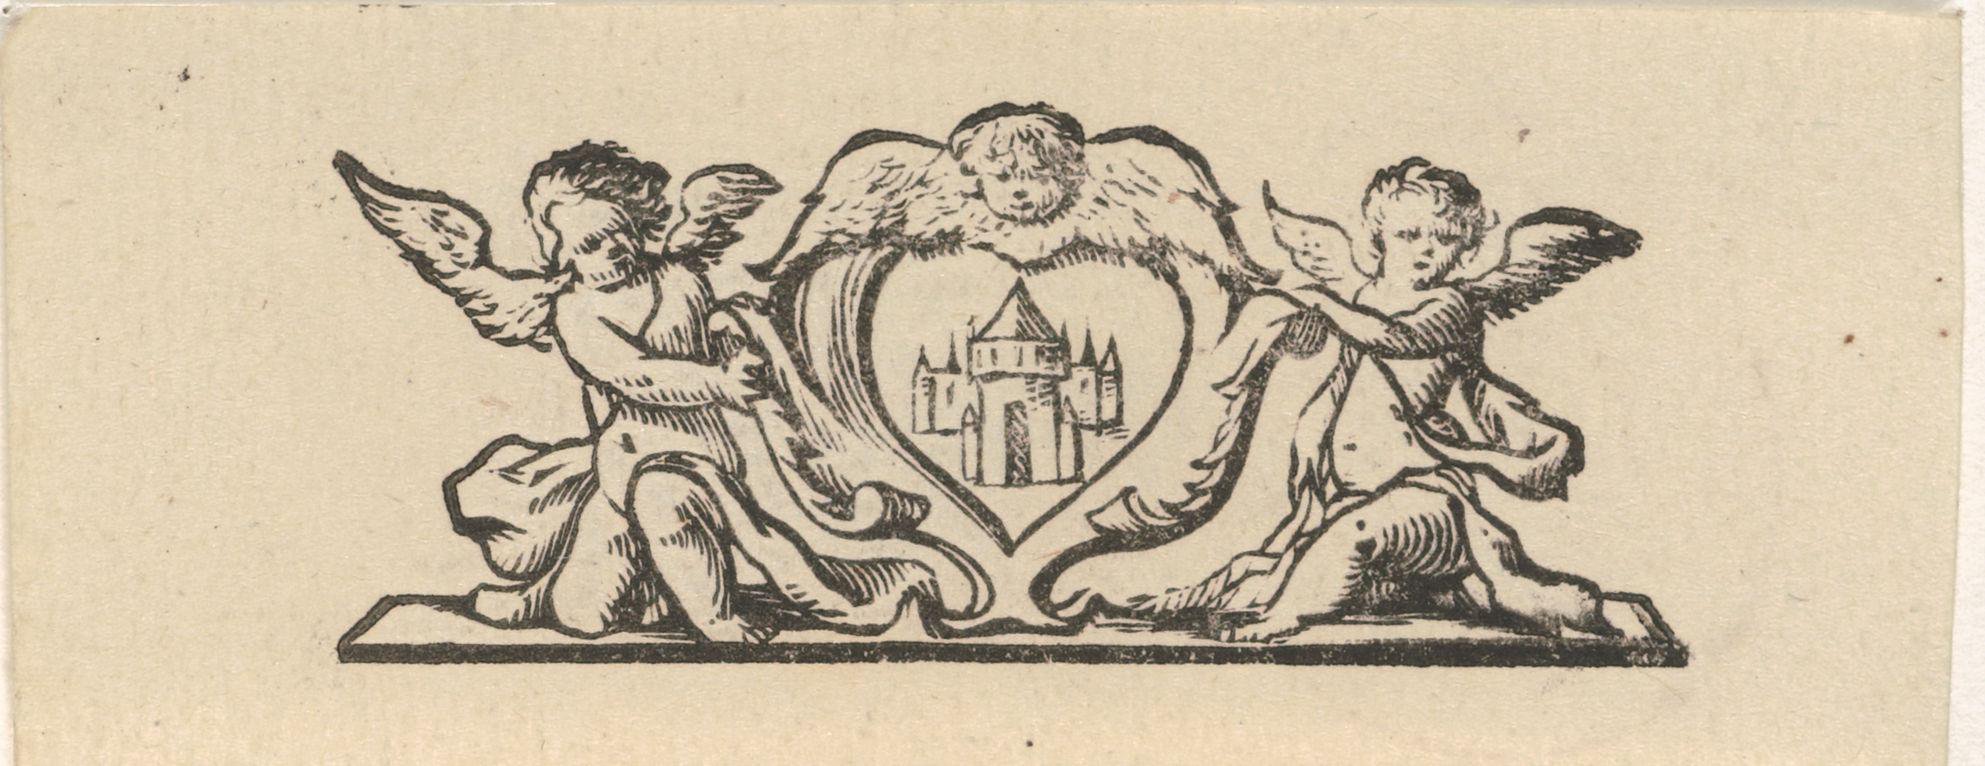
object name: print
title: Vignet met een hartvorm en een kasteel, twee putti en een cherubijn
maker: dirck de bray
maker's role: draughtsman, painter, print maker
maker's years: 1625-1694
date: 1635-1694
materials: paper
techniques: woodcut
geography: netherlands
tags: cherubs, i.e. children's heads with wings, castle, vignette, cupids: 'amores', 'amoretti', 'putti'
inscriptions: collector's mark: Lugt 240